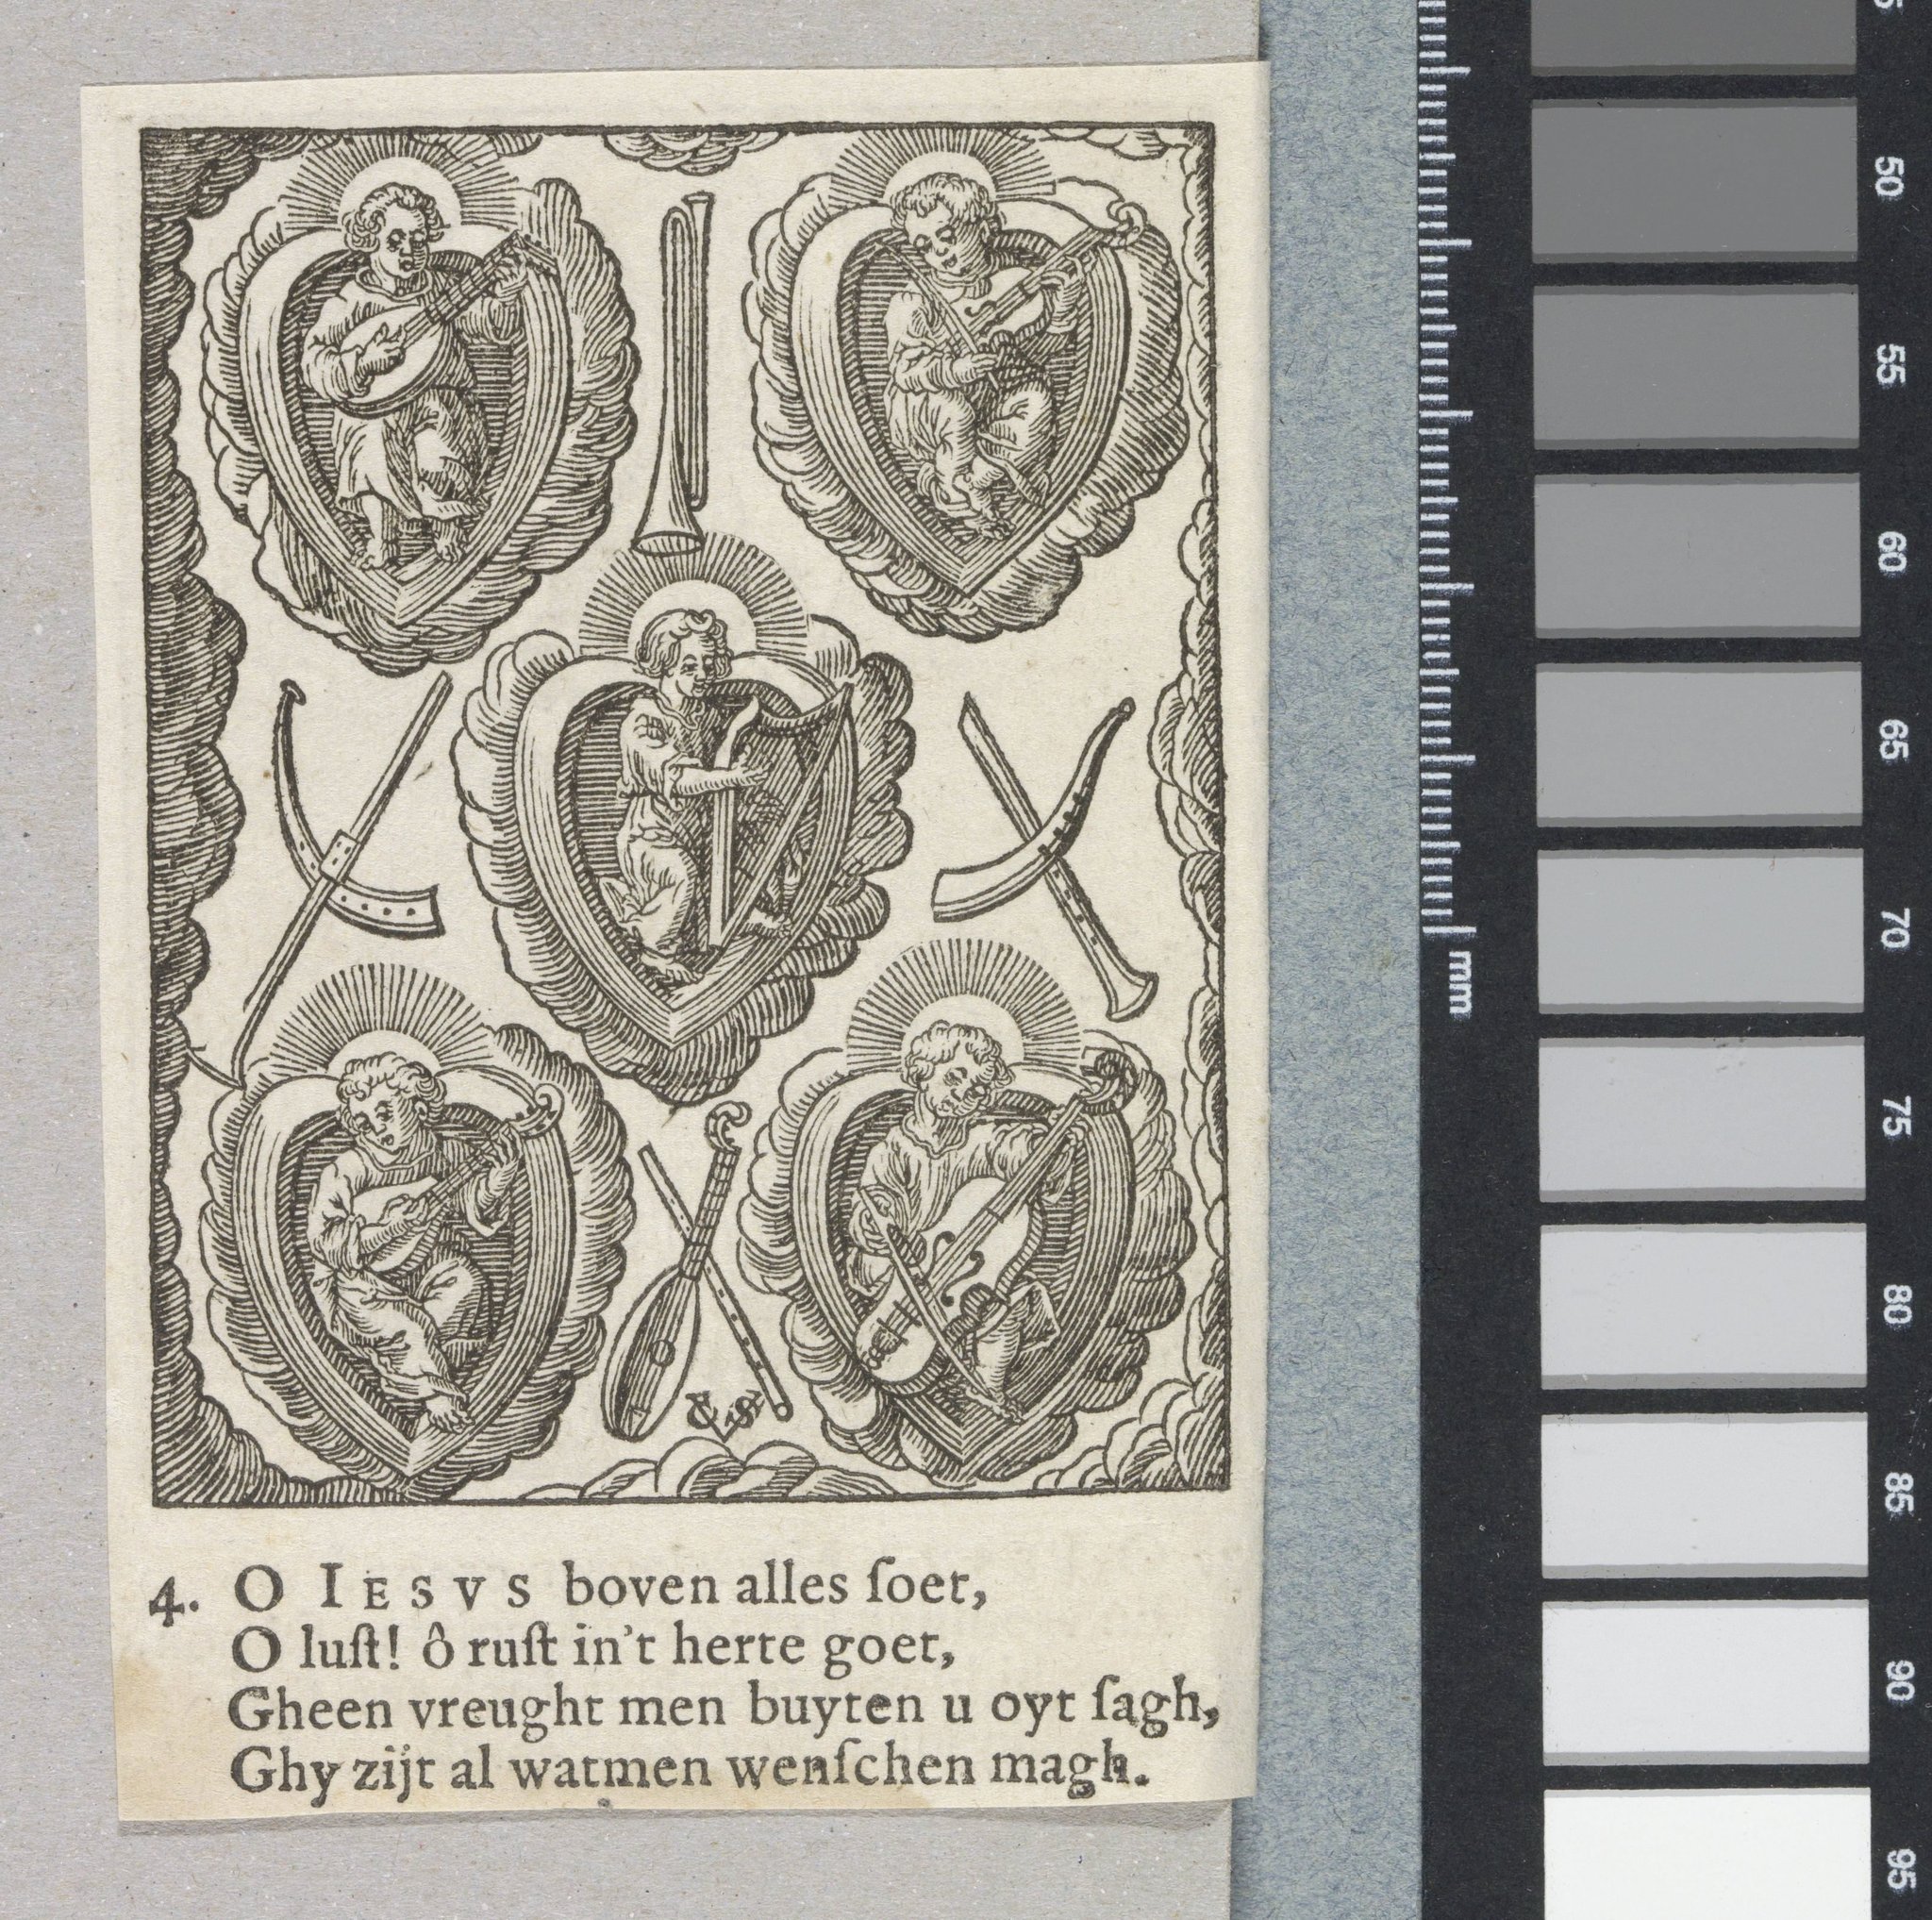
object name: print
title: Aanbidding van het Christuskind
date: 1629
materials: paper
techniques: letterpress printing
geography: amsterdam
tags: christ-child (with attributes), string instruments (plucked)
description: De prent is afkomstig uit een van de uitgaven van P.J. Paets uit Amsterdam. De prent wordt voor het eerst gebruikt in: Der Zielen Lust-hof. Leuven, I.Jacbosz voor P.J. Paets [= Amsterdam, P.J. Paets], 1629.